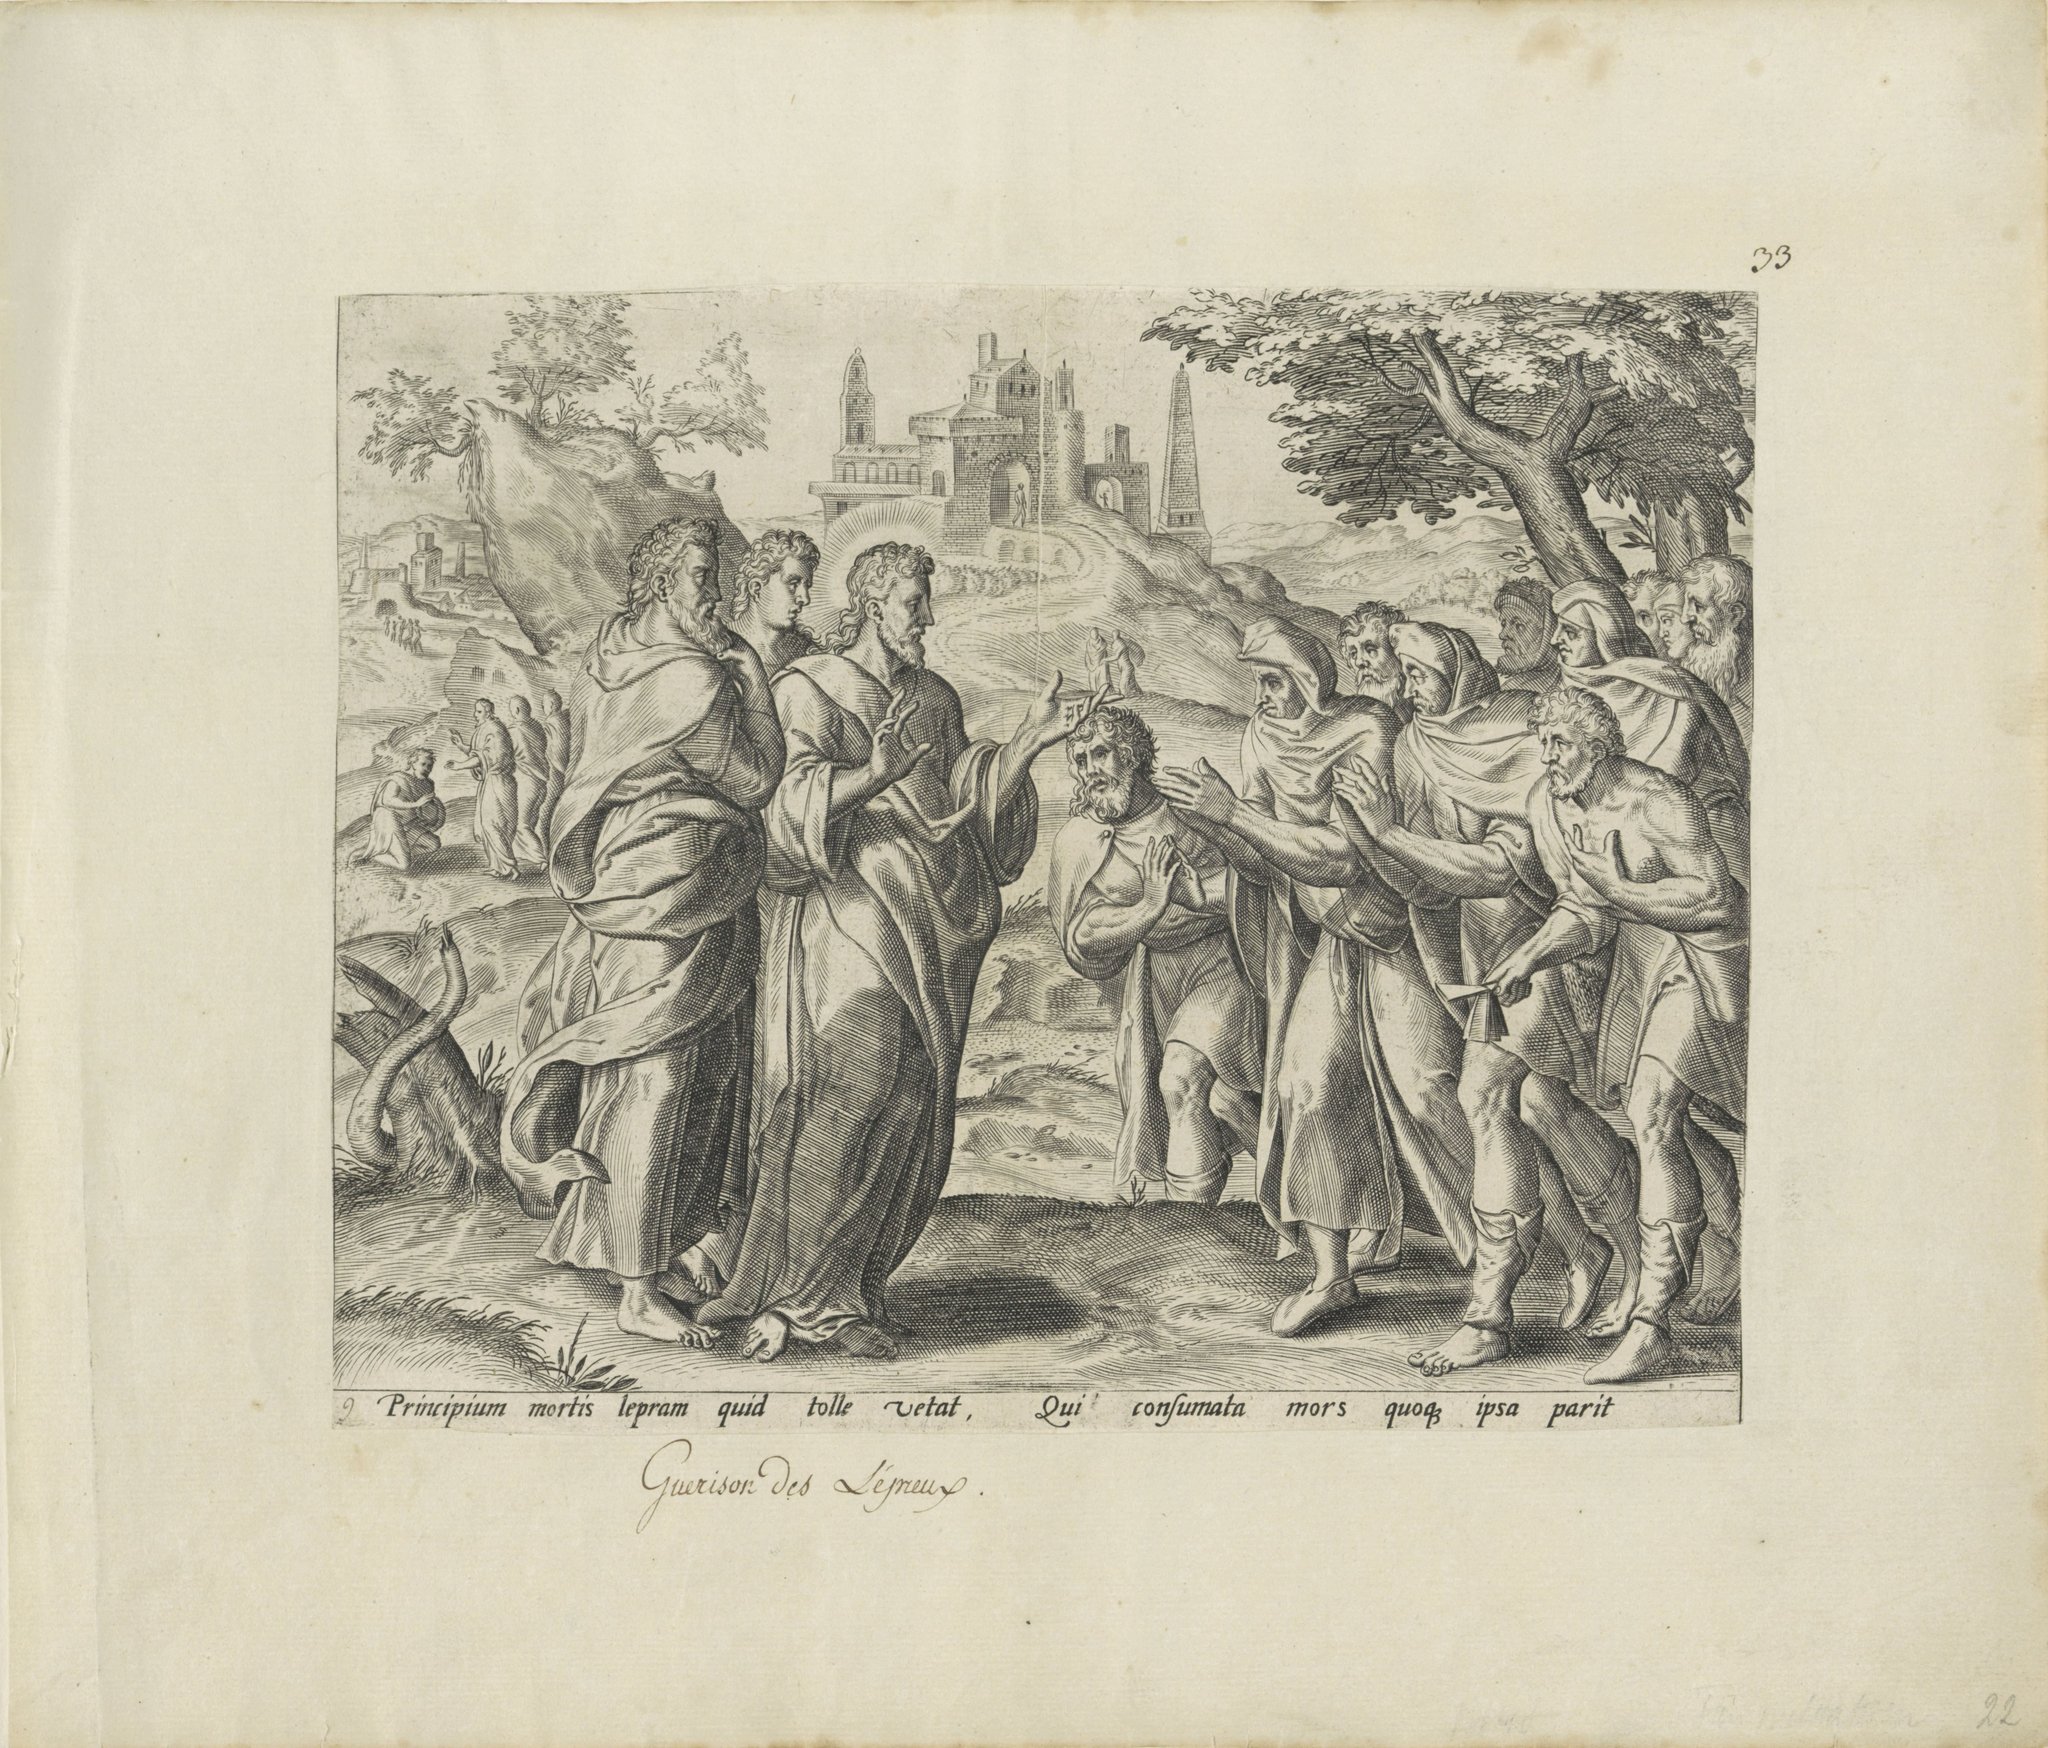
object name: print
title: Christus geneest tien melaatsen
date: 1579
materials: paper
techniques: engraving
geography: antwerp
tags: one leper, a samaritan, sent to the priest by christ, returns and kneels before him, christ sends ten lepers to the priest (luke 17:11-19)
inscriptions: inscription: ‘Guerison des Lépreux’, collector's mark: Lugt 2228, number: ‘33’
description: Christus ontmoet tien mensen die aan huidvraat lijden en geeft hen de opdracht om zich aan de priesters te laten zien. Als ze dat doen blijkt dat ze zijn genezen. Slechts een van de tien, een Samaritaan, keert links op de achtergrond terug en knielt voor Christus om hem te bedanken. Onder de voorstelling een verwijzing in het Latijn naar de Bijbeltekst.